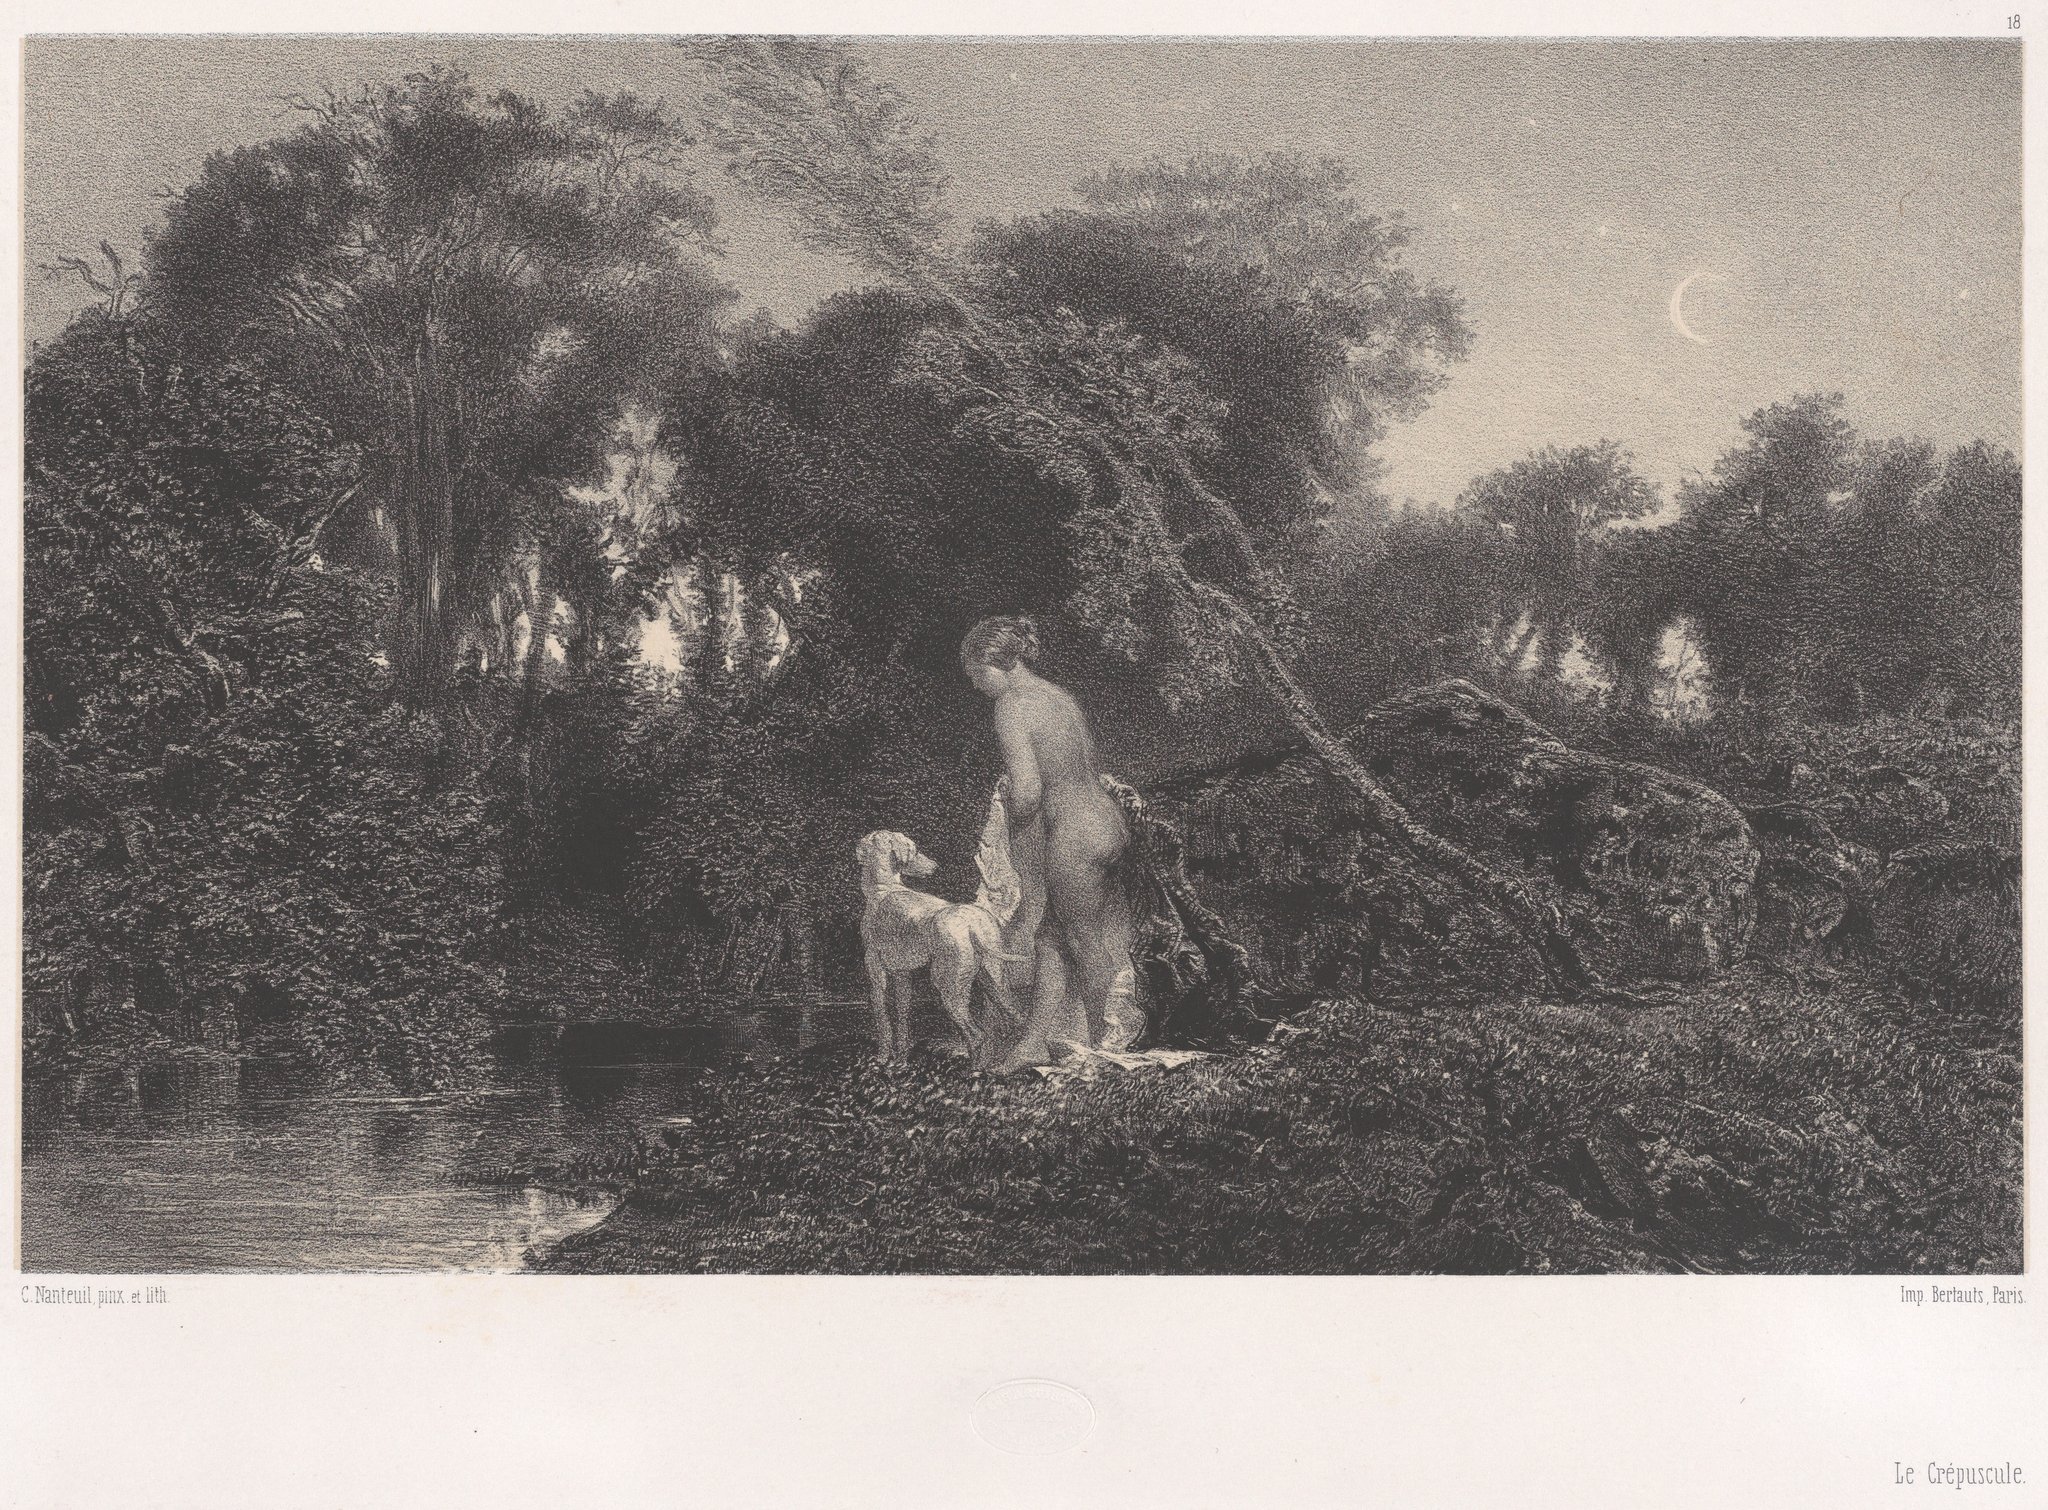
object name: print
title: Twilight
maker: célestin nanteuil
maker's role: artist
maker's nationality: french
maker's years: 1813-1873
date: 1850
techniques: lithograph